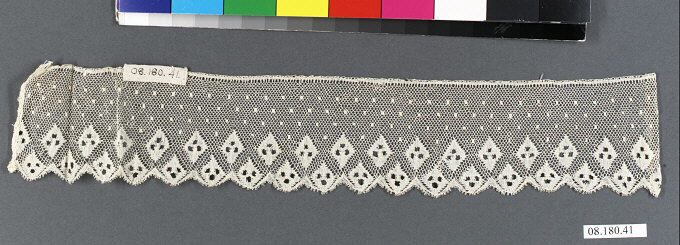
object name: piece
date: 1801-1833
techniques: lace